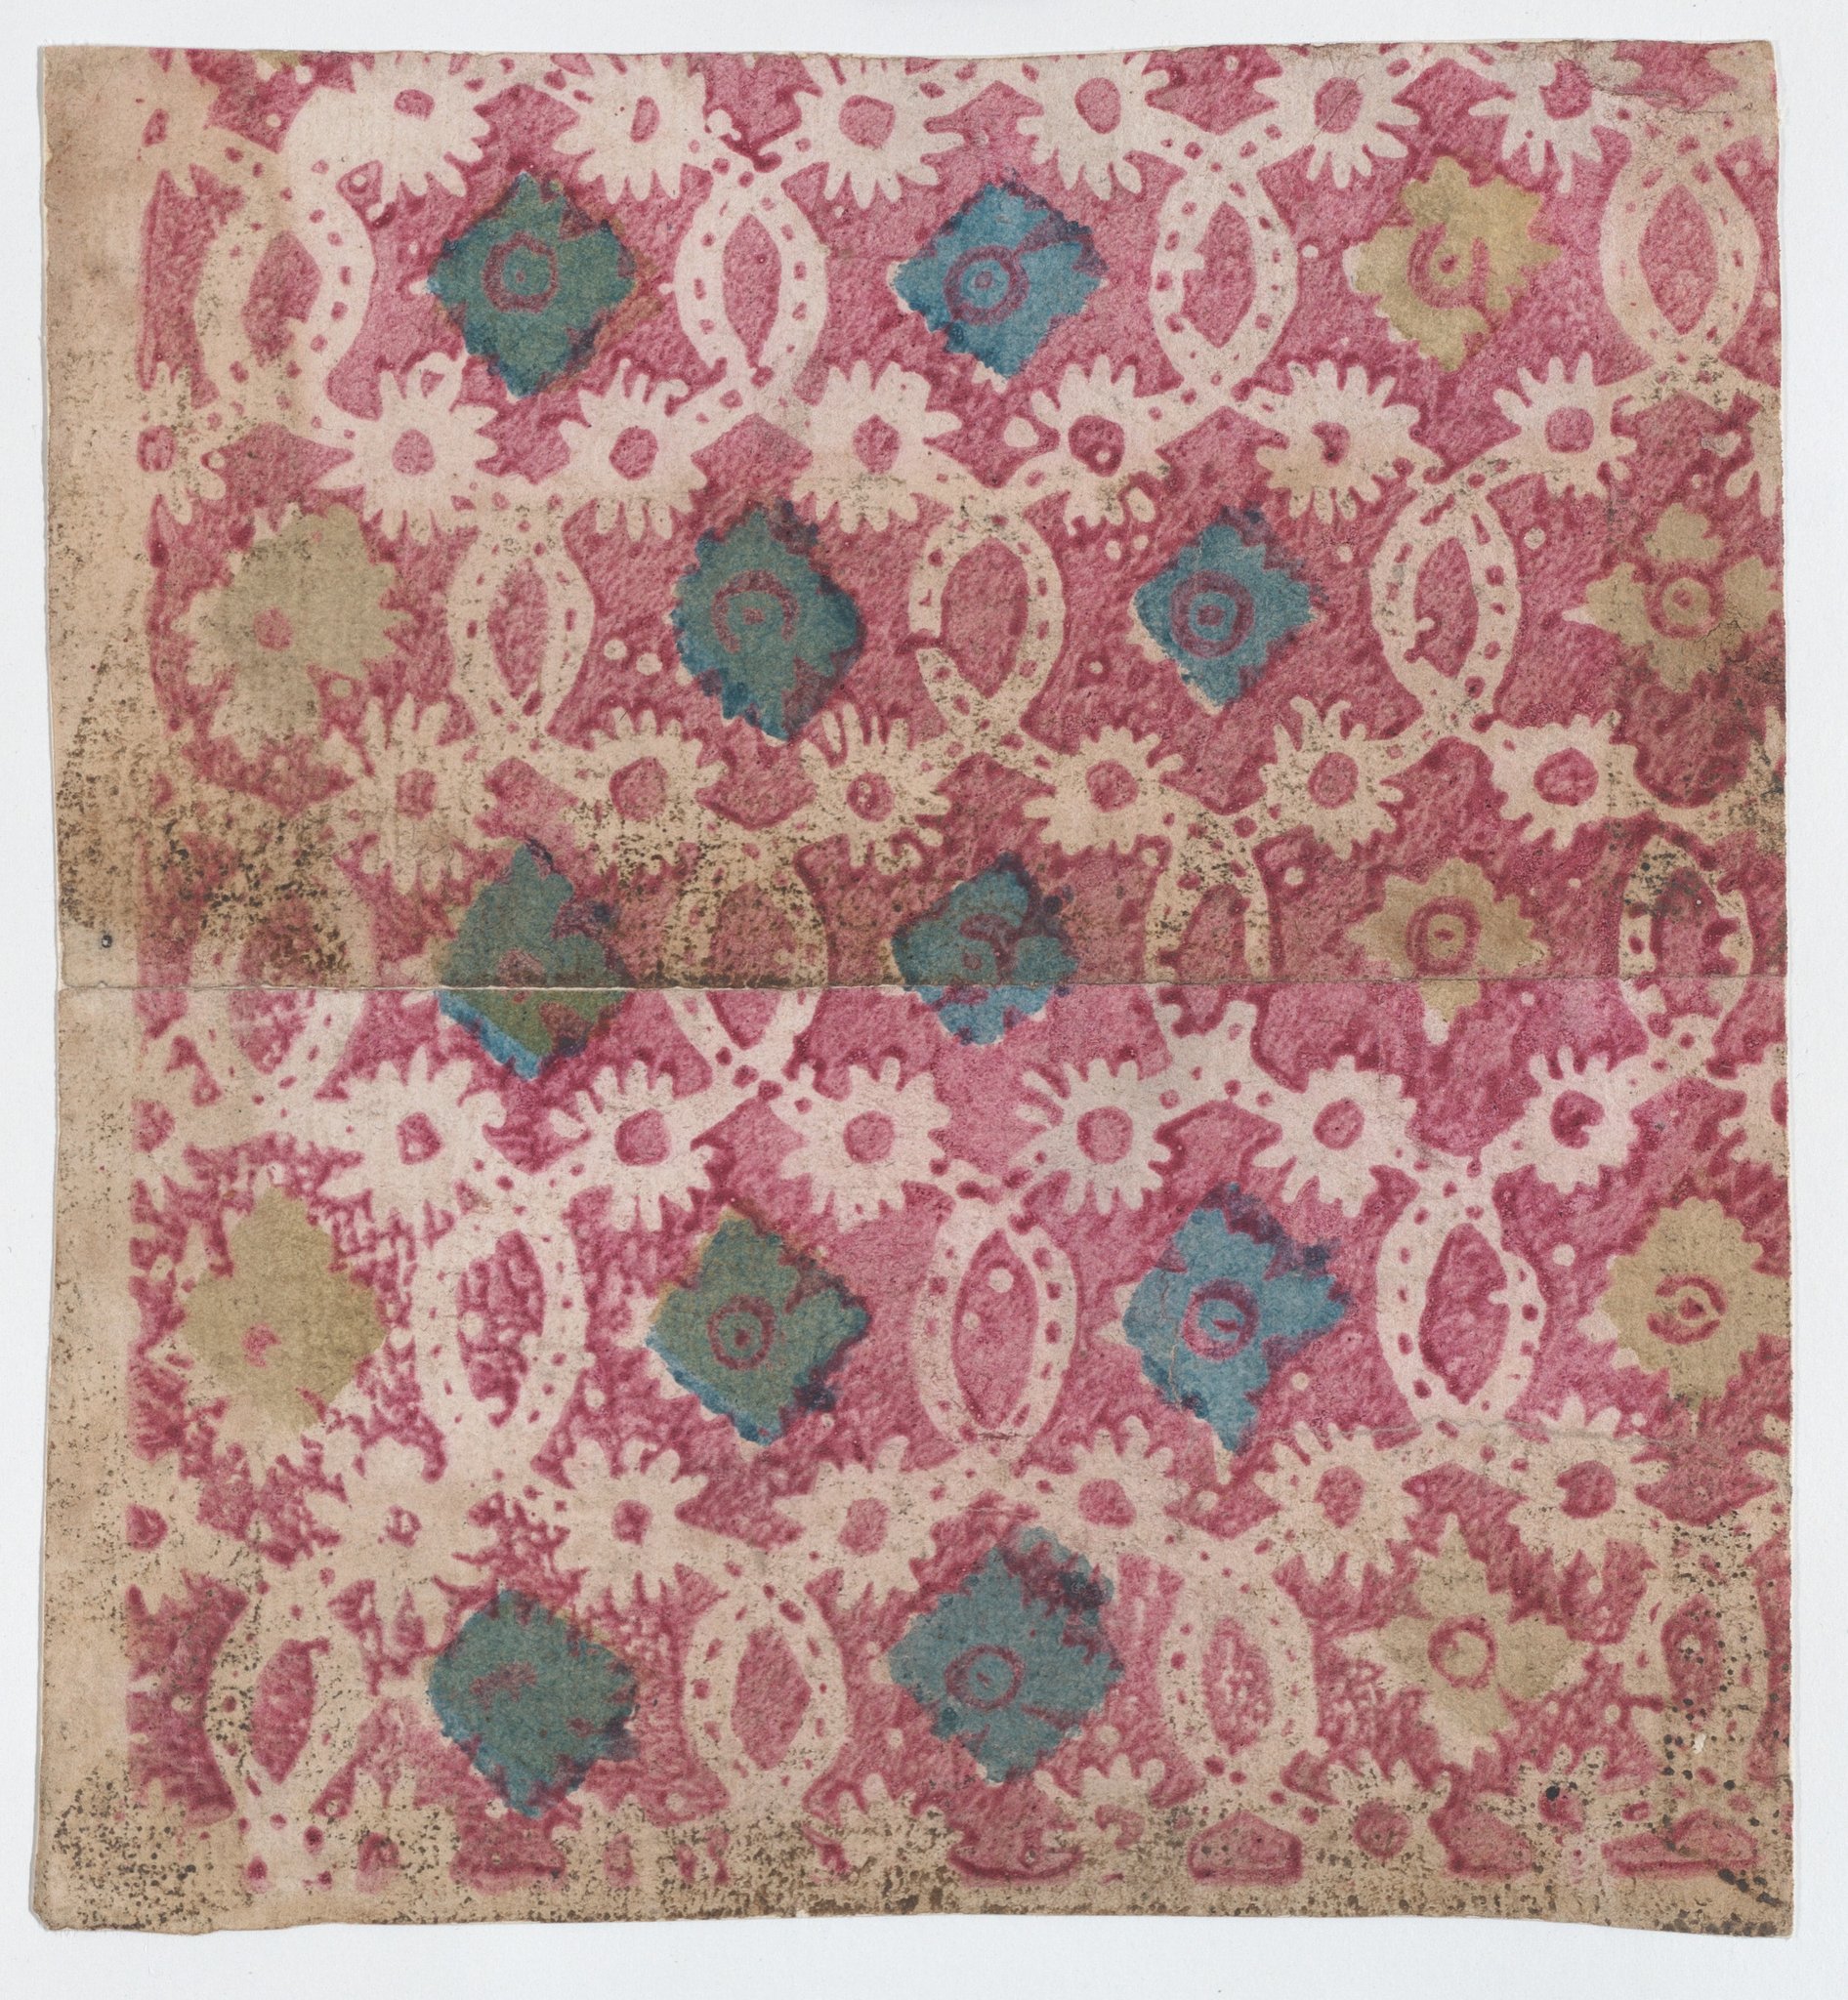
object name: print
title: Sheet with overall lattice pattern with rosettes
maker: Anonymous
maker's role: artist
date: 1801-1900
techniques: relief print